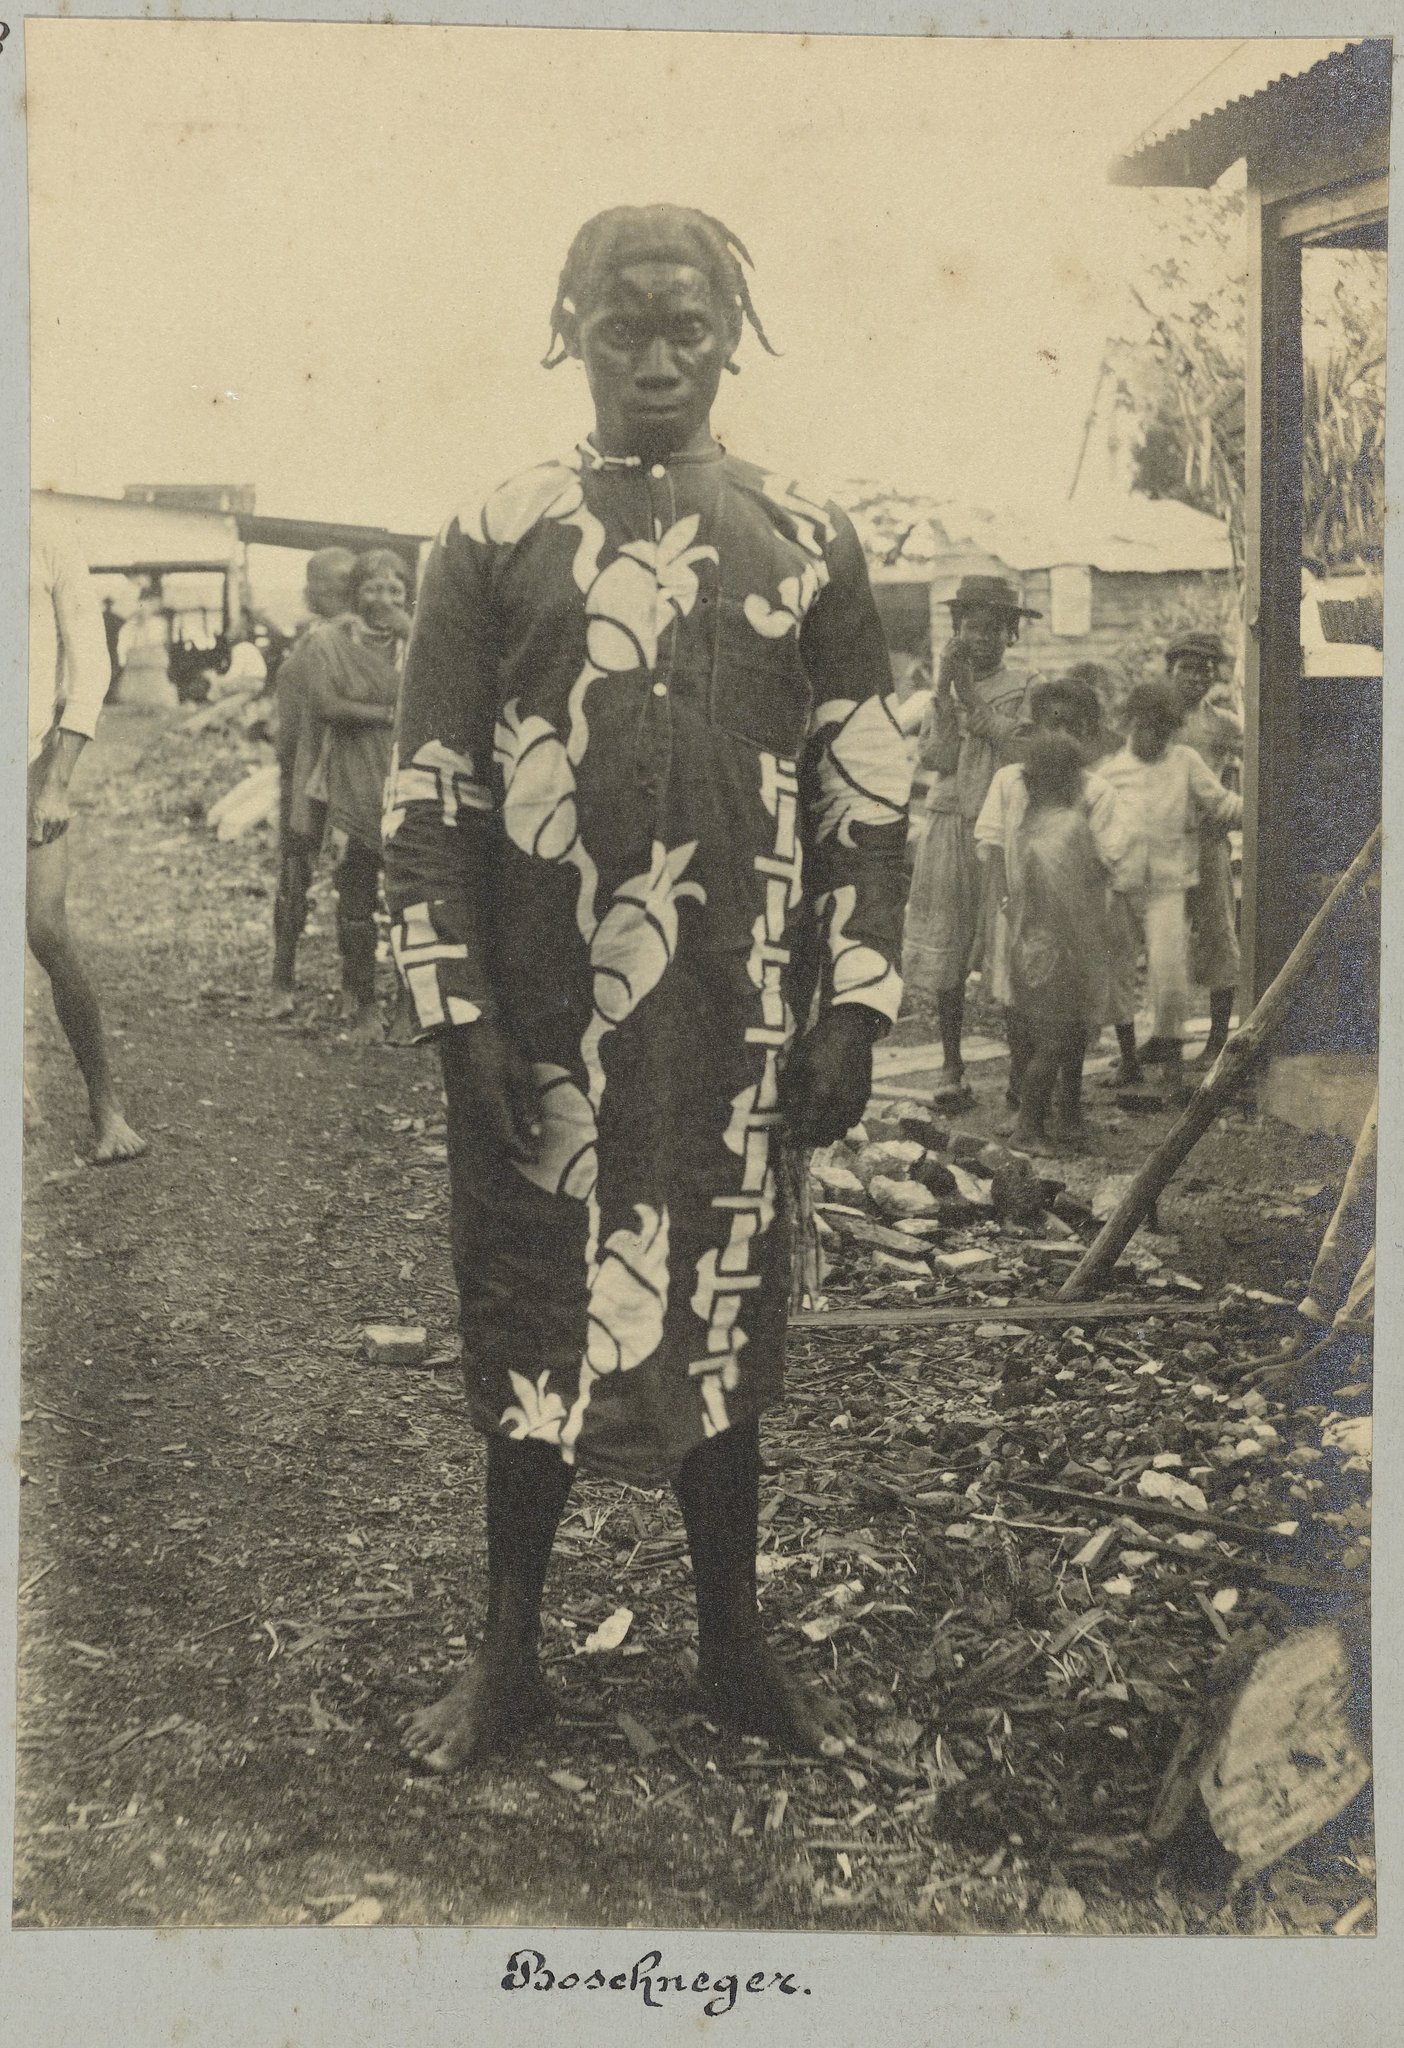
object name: photograph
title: Boschneger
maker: hendrik doijer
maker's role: engineer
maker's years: 1863-1925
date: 1903-1910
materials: photographic support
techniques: gelatin silver print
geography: suriname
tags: suriname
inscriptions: inscription: ‘B1. / Boschneger.’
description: Een staand poserende jongeman van de Marrons. Onderdeel van het fotoalbum Souvenir de Voyage (deel 1), over het leven van de familie Doijer in en rond de plantage Ma Retraite in Suriname in de jaren 1903-1910.